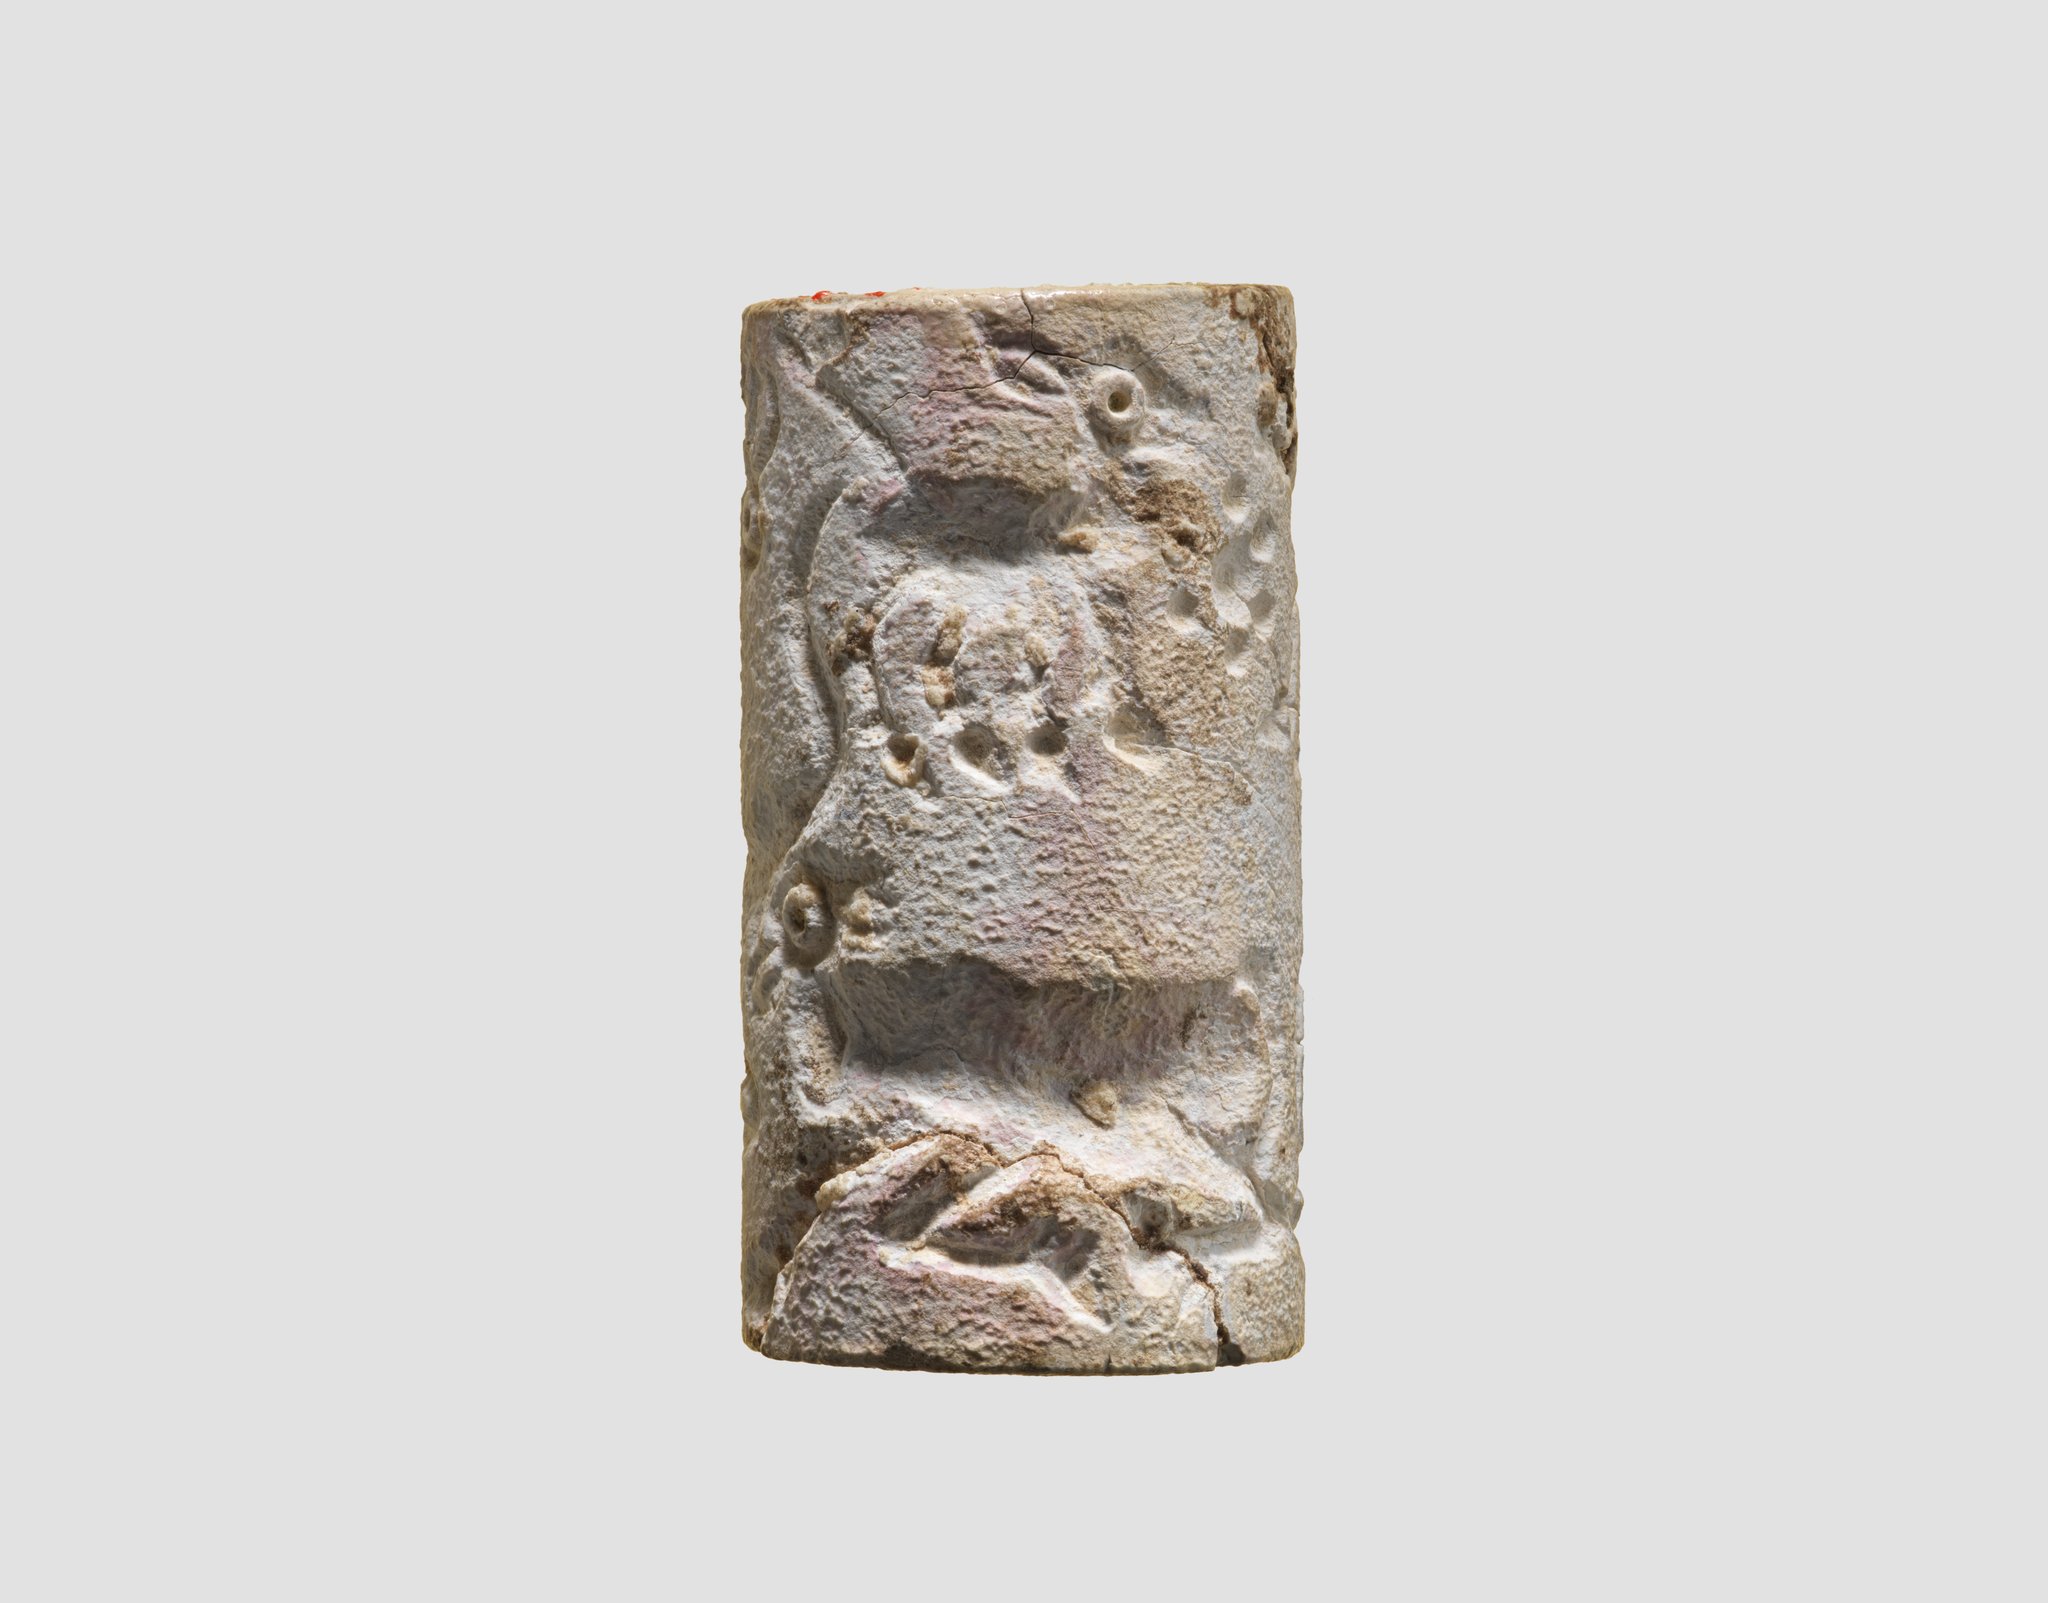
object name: cylinder seal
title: Cylinder seal and modern impression: two horned animals, rosettes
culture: proto-elamite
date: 3100-2900 BCE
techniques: glazing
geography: iran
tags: animals